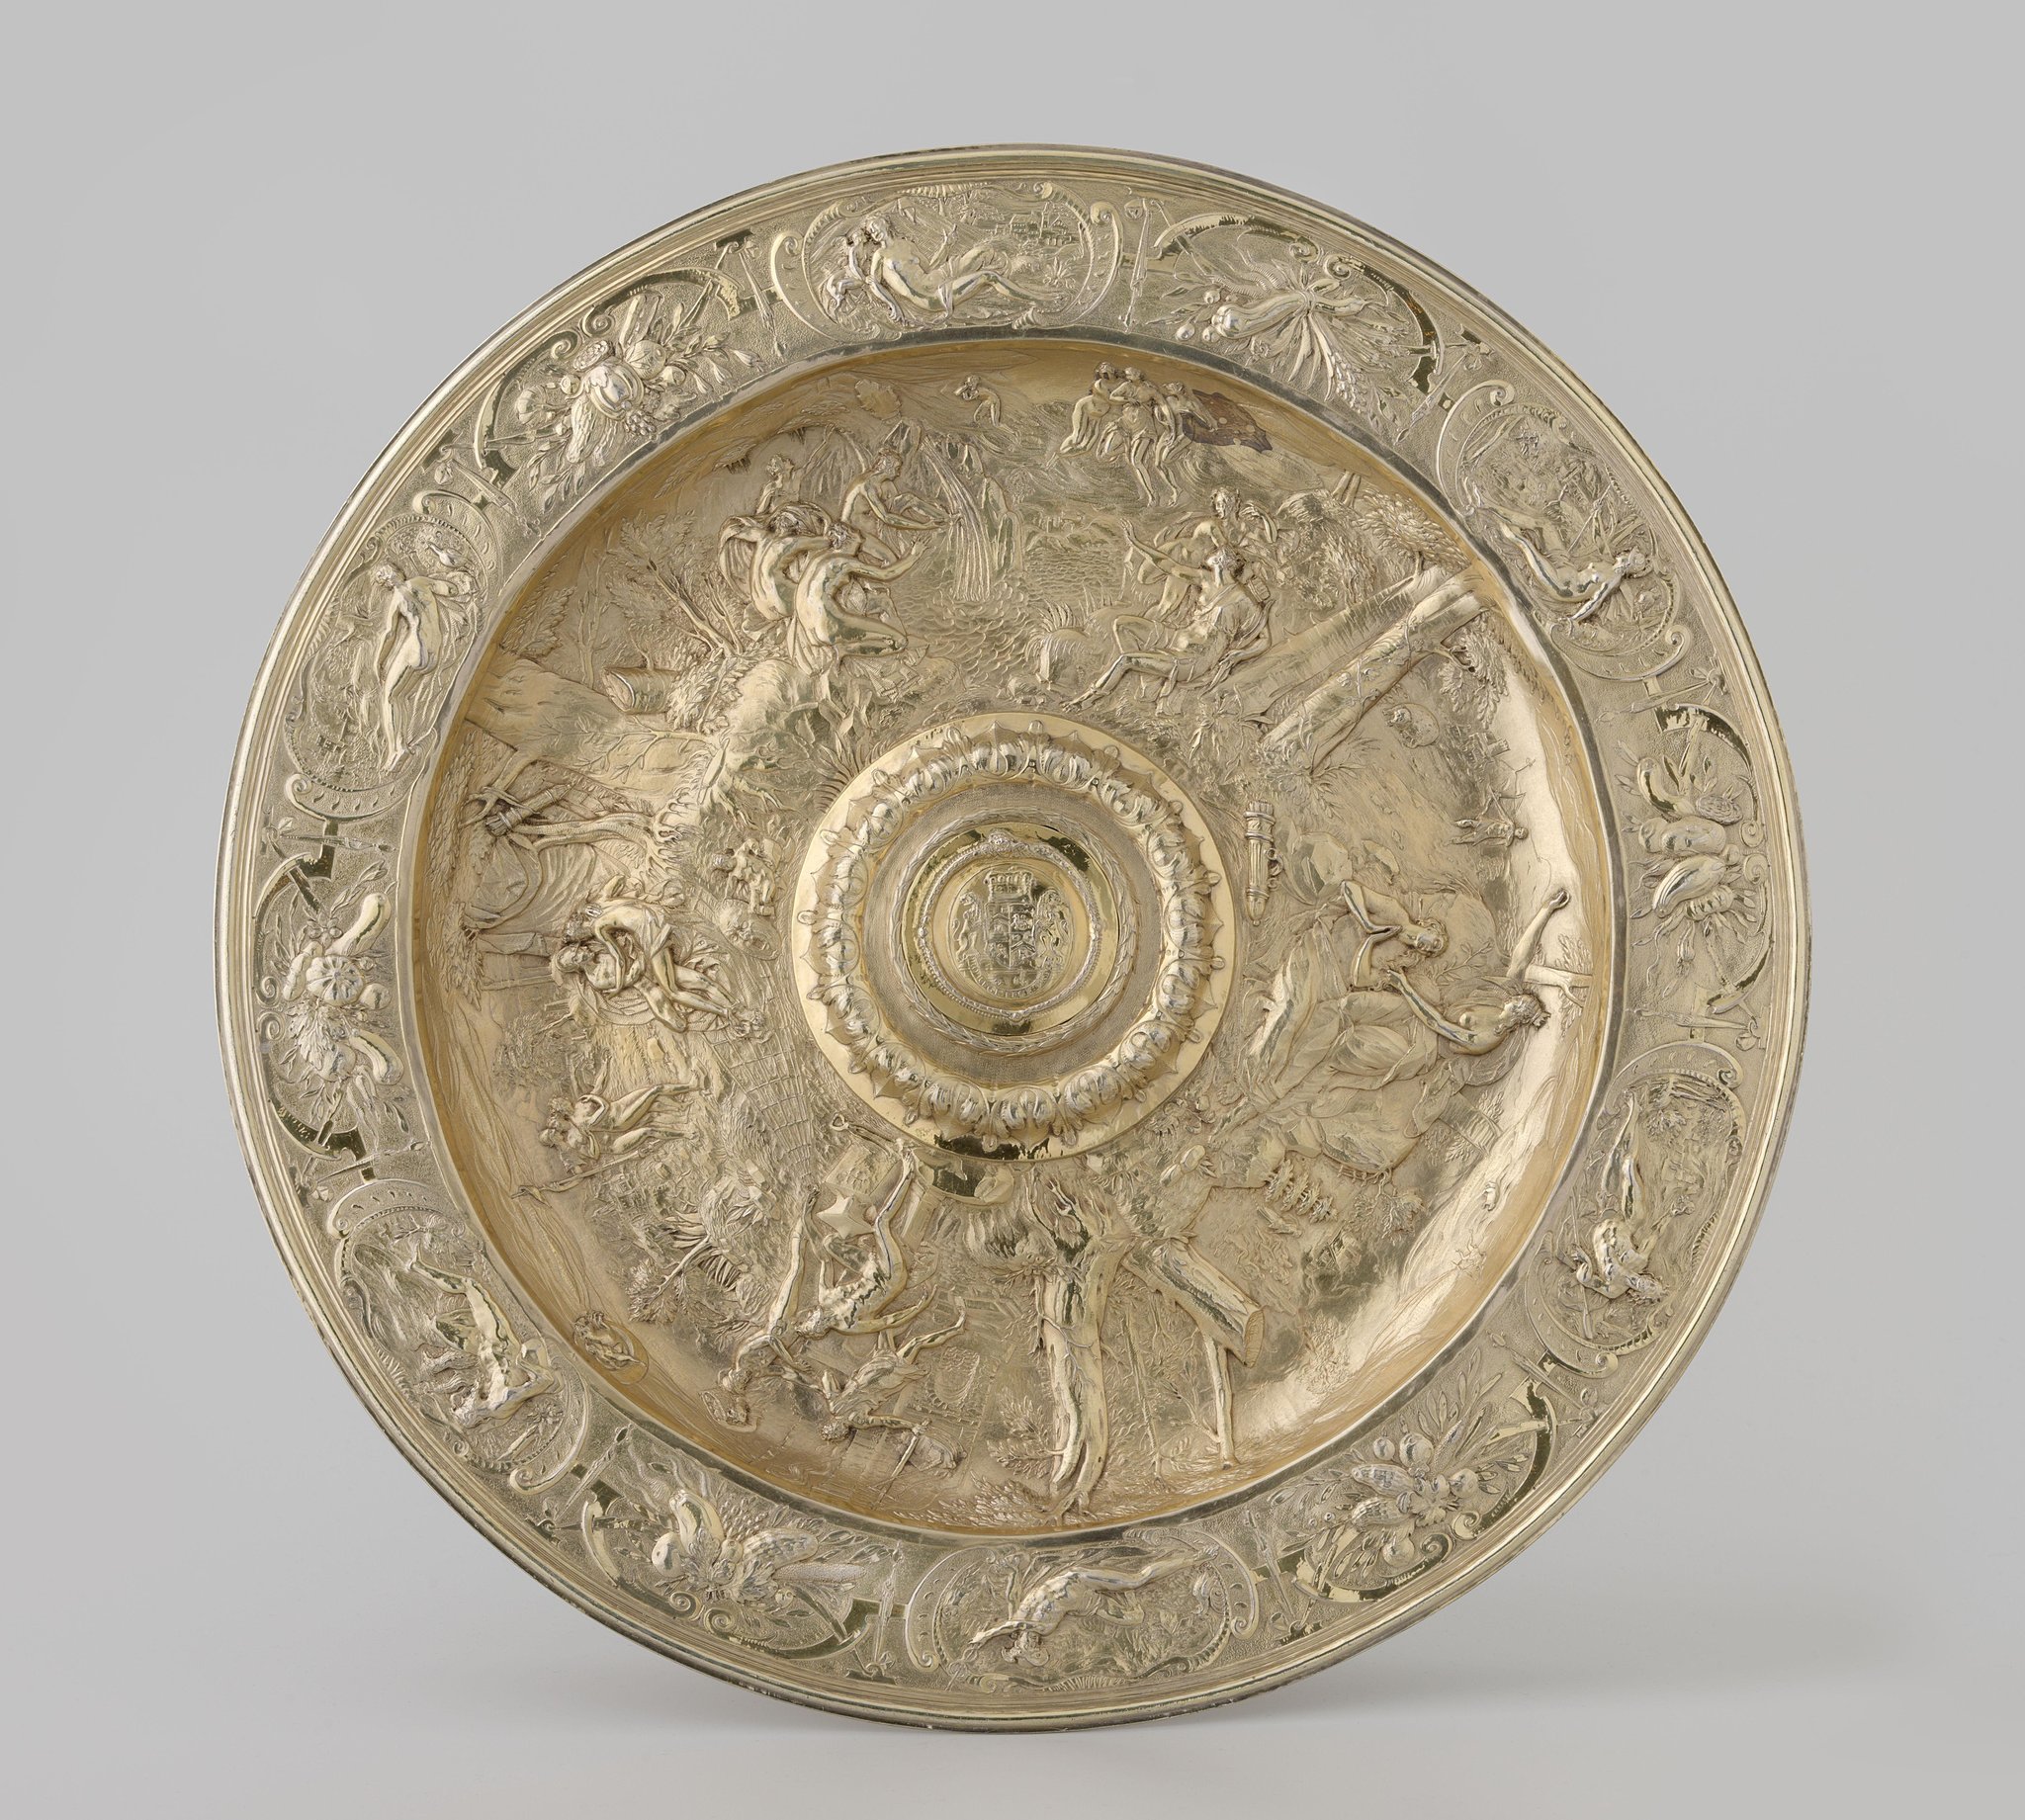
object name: dish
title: Schaal met twaalf gedreven cartouches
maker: Anonymous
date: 1600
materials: silver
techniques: gilding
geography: germany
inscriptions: mark: ‘GB’, mark: ‘MAF’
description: Ewer and basin. Silver-gilt. Germany?, c. 1600. The scenes of Mercury and Argus on the ewer and of Diana and Callisto and Callisto and Juno on the basin are based on compositions by Paulus van Vianen. On the basin the arms of Brabazon Ponsonby, Earl of Bessborough (1679-1758) and his first wife, Sarah Margetson. Gift of the Committee for Photographic Sales.